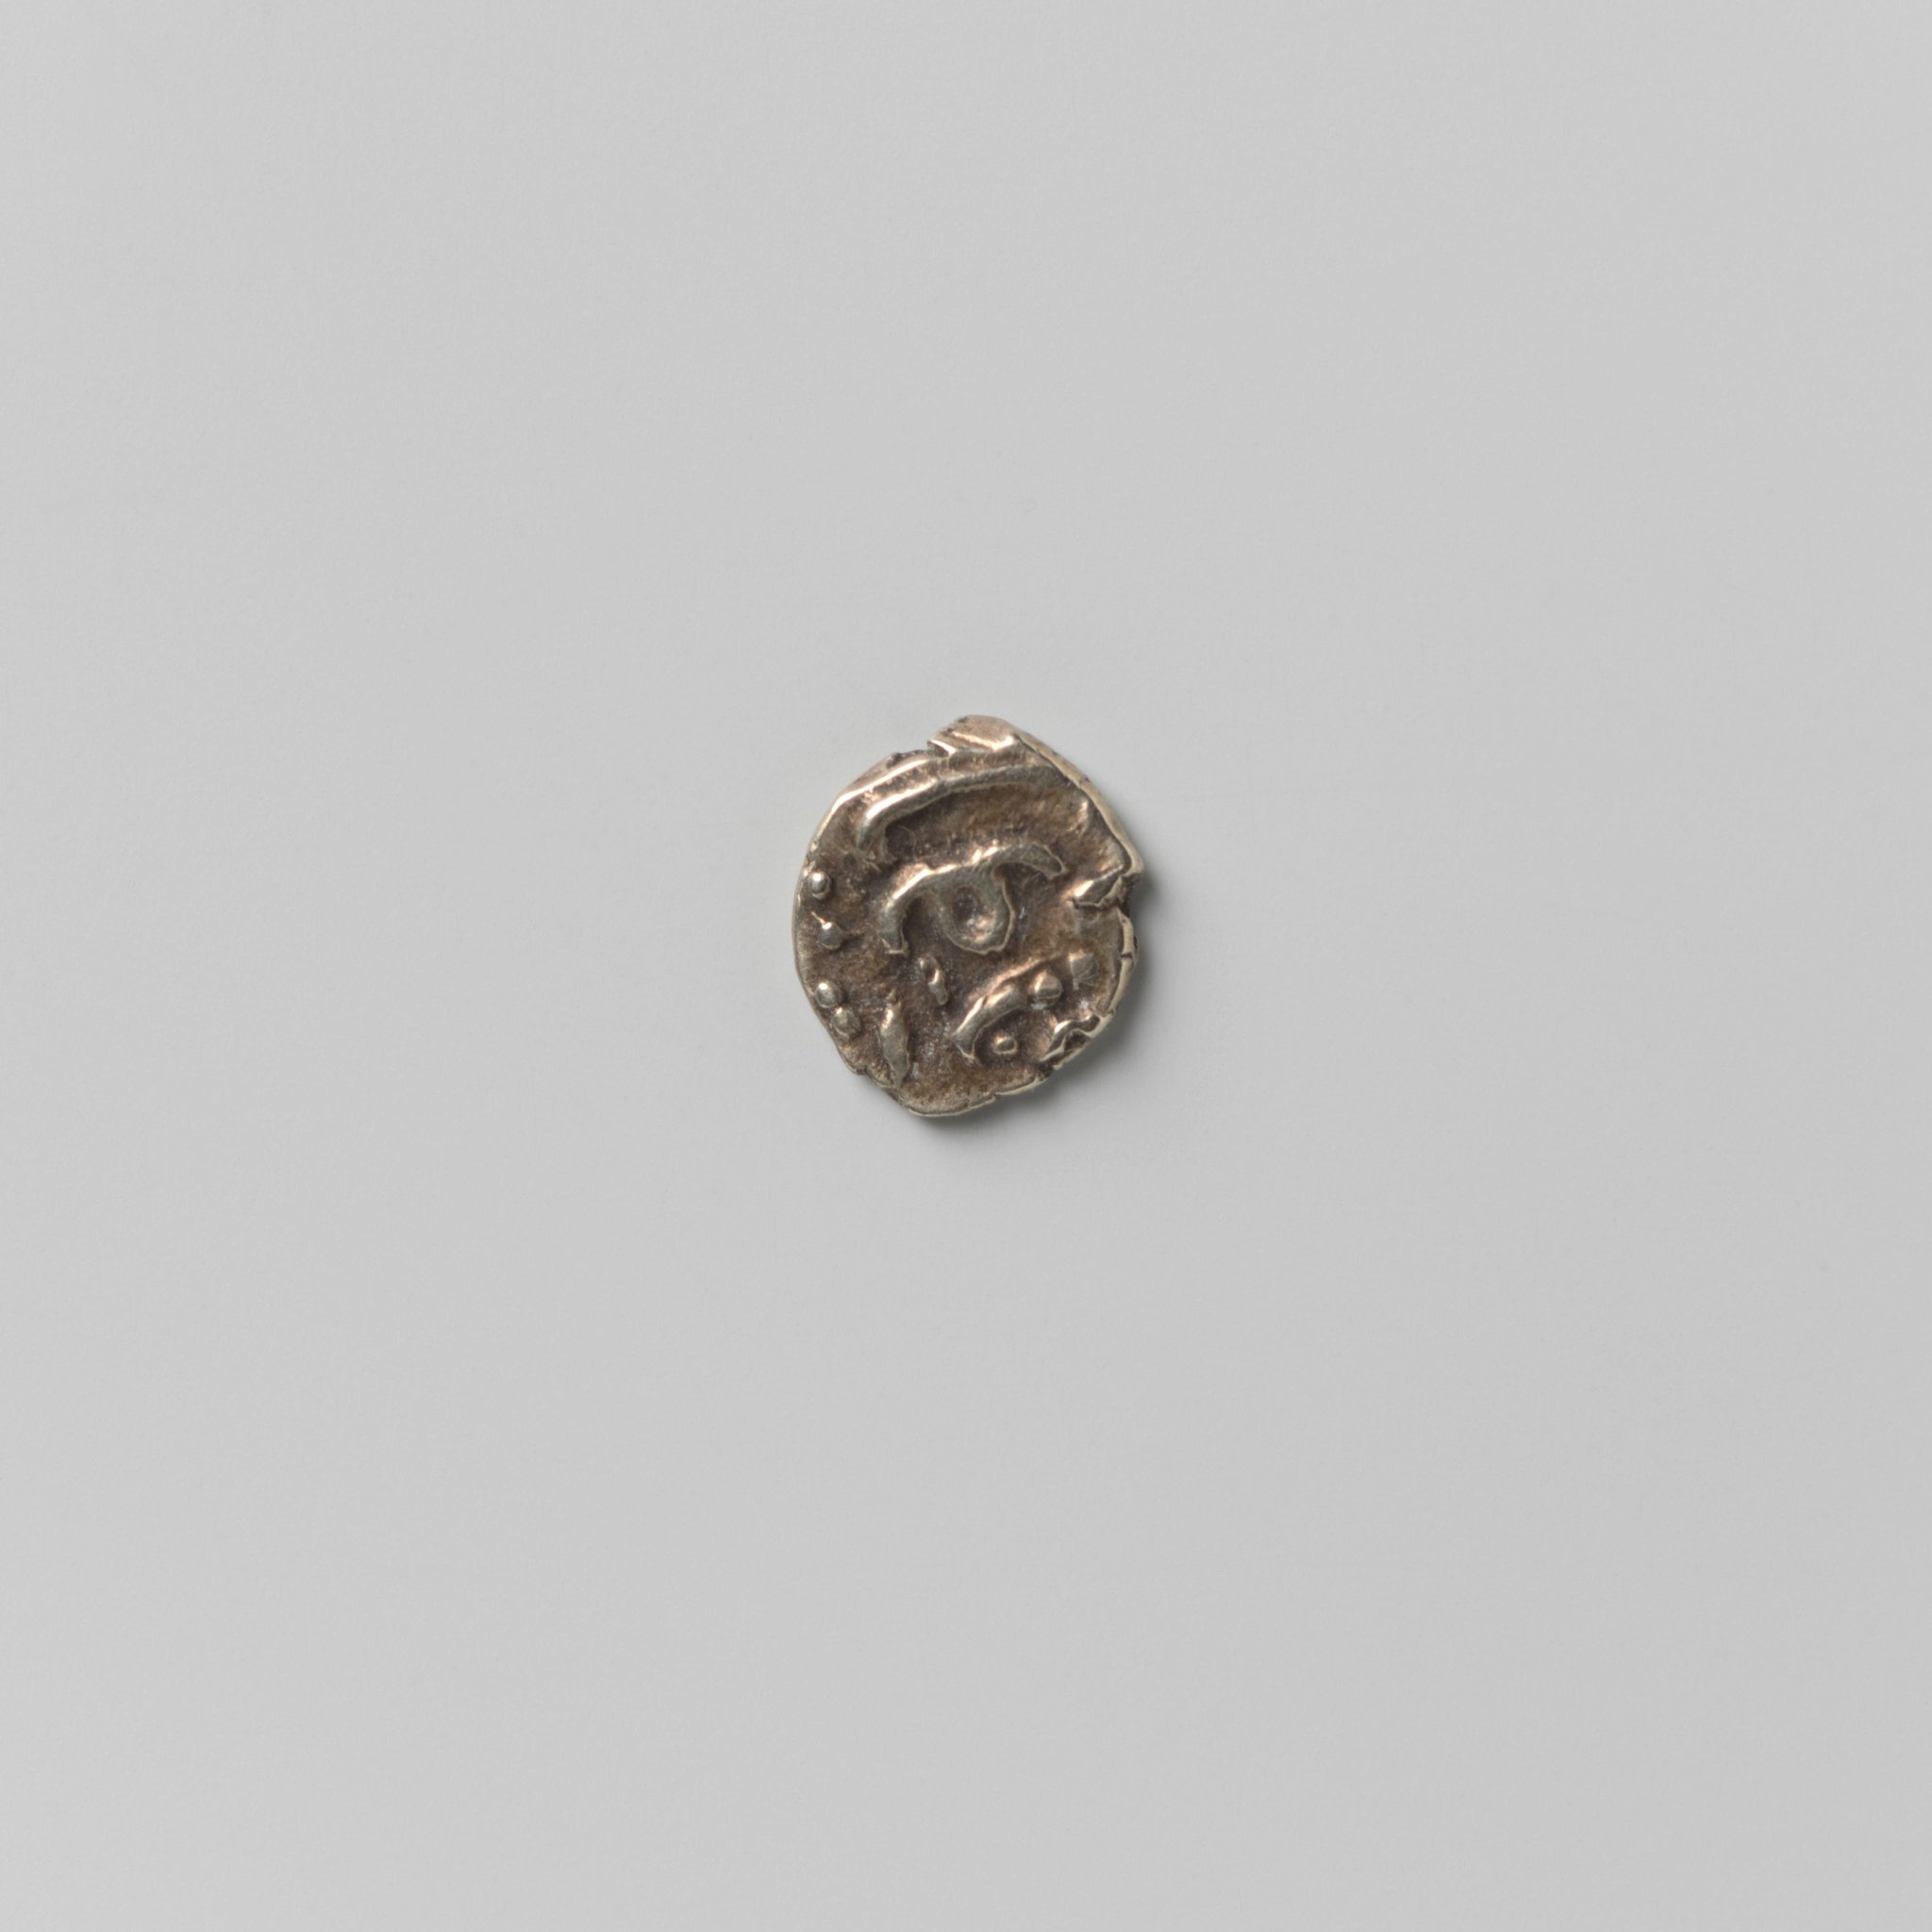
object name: coin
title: VOC, Paliakate, Voor-Indië, gouden fanam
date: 1650-1675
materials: gold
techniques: striking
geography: paliacatta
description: Gouden munt. Voorzijde: verbastering van een menselijk figuur, Kali voorstellend, op zijn borst een halve maan en een krans van punten. Keerzijde: verbastering van een drieregelig opschrift in Arabische lettertekens. Gladde rand.